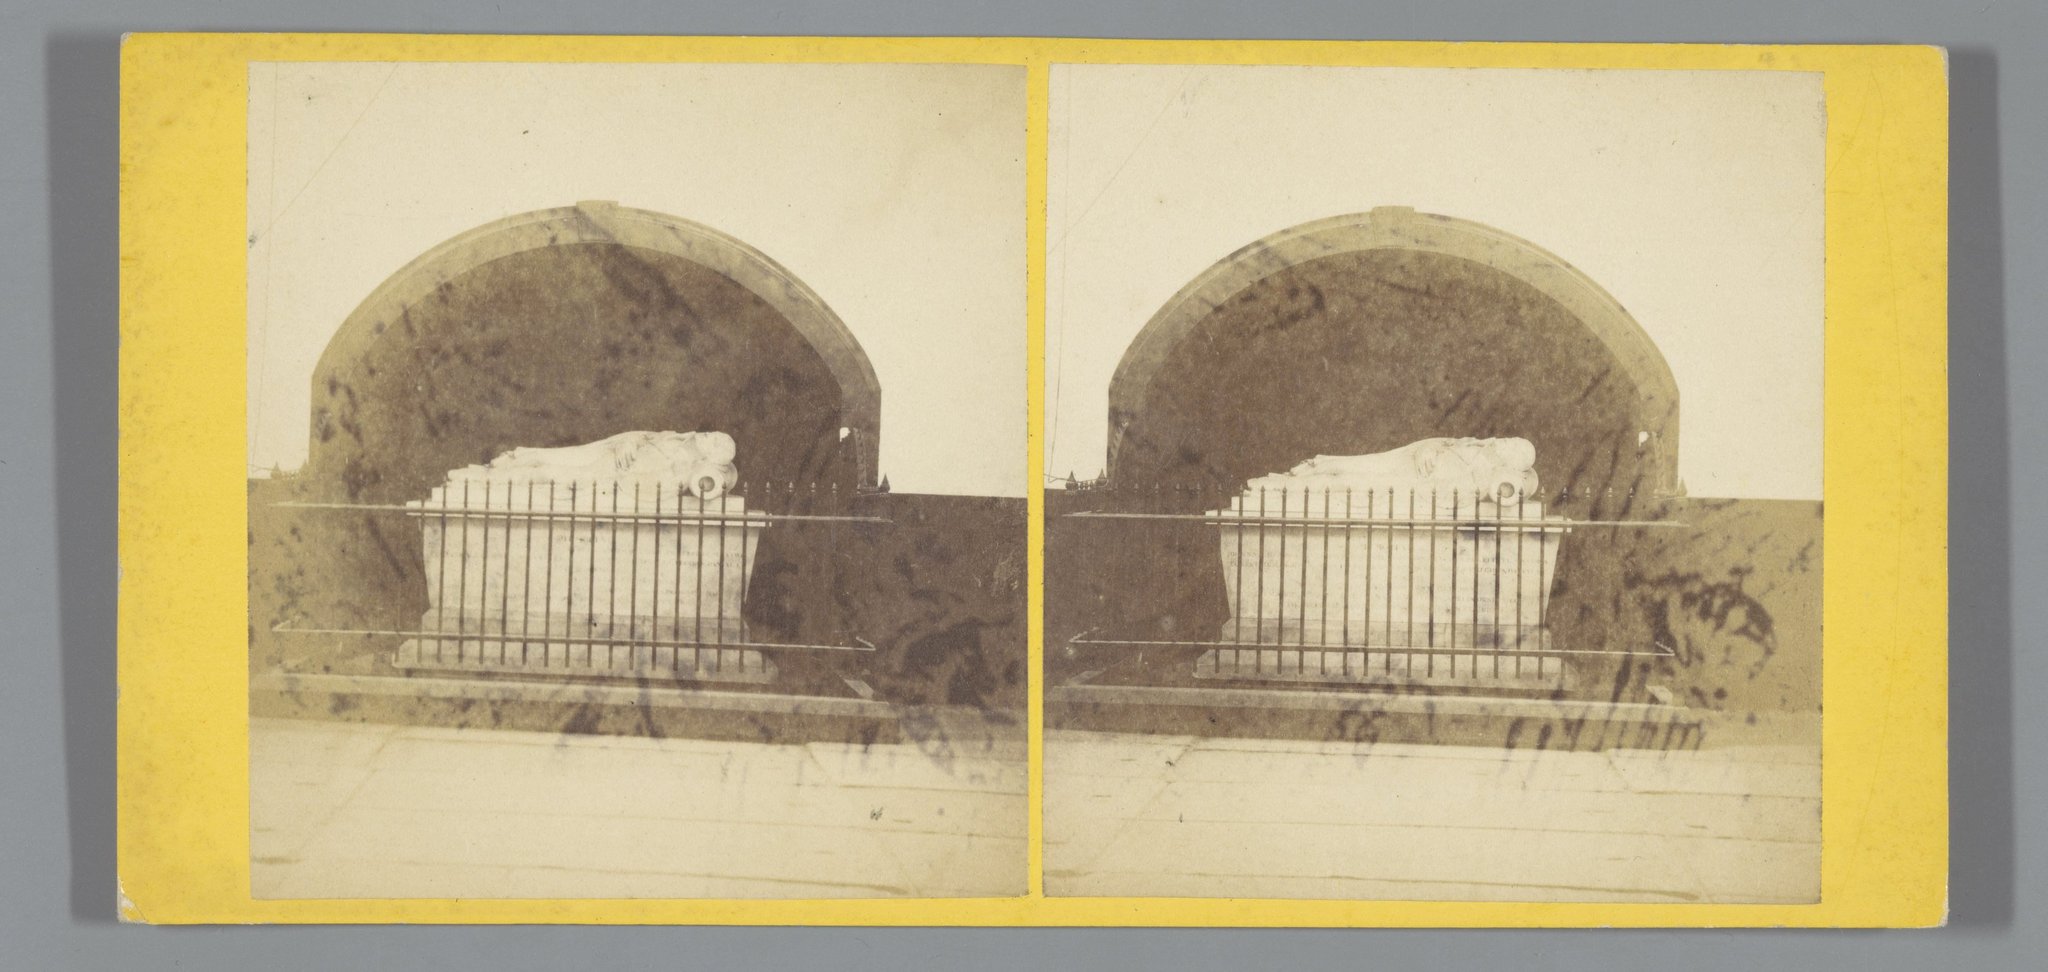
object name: stereograph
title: Gezicht op het grafmonument van Jan Hendrik van Kinsbergen in de Nieuwe Kerk in Amsterdam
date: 1860-1885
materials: cardboard, photographic support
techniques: albumen print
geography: amsterdam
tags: jonkheer jan hendrik van kinsbergen, grave, tomb, interior of church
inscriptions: number: ‘4.5’, inscription: ‘HET GRAF VAN DEN LUIT.-ADMIRAAL/ VAN KINSBERGEN,/ in de Nieuwe Kerk te Amsterdam./ A. JAGER, WATER 110, TE AMSTERDAM.’